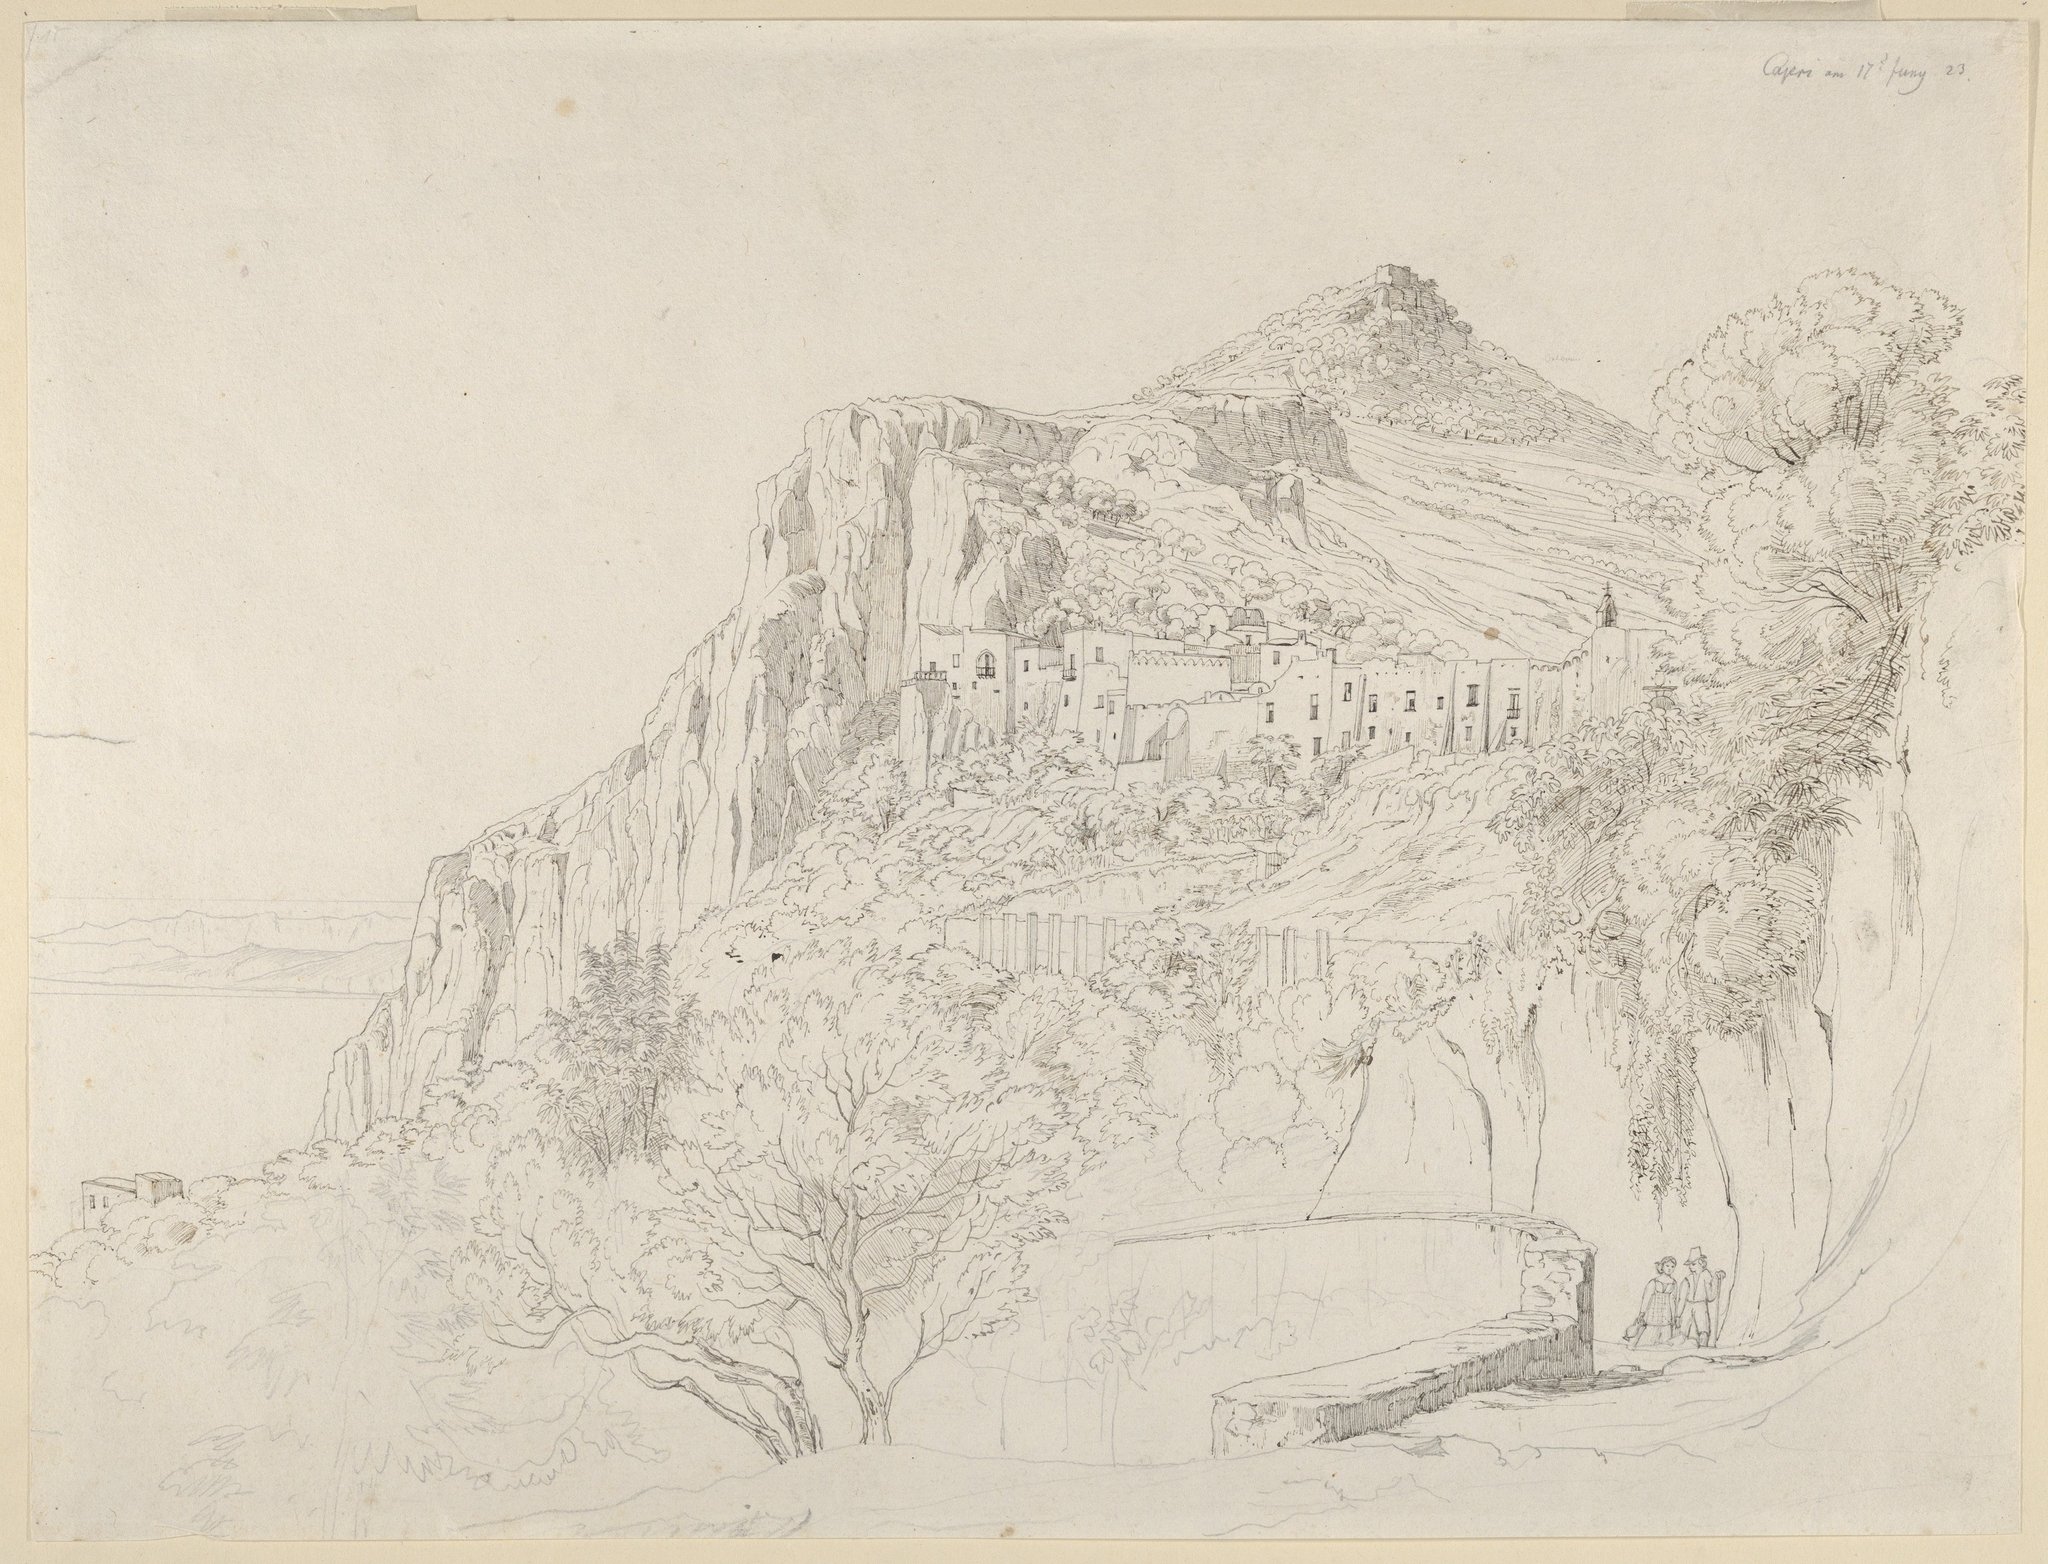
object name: drawing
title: View of Capri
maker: carl wagner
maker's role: artist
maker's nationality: german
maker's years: 1796-1867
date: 1823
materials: graphite, ink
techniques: pen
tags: buildings,landscapes,trees